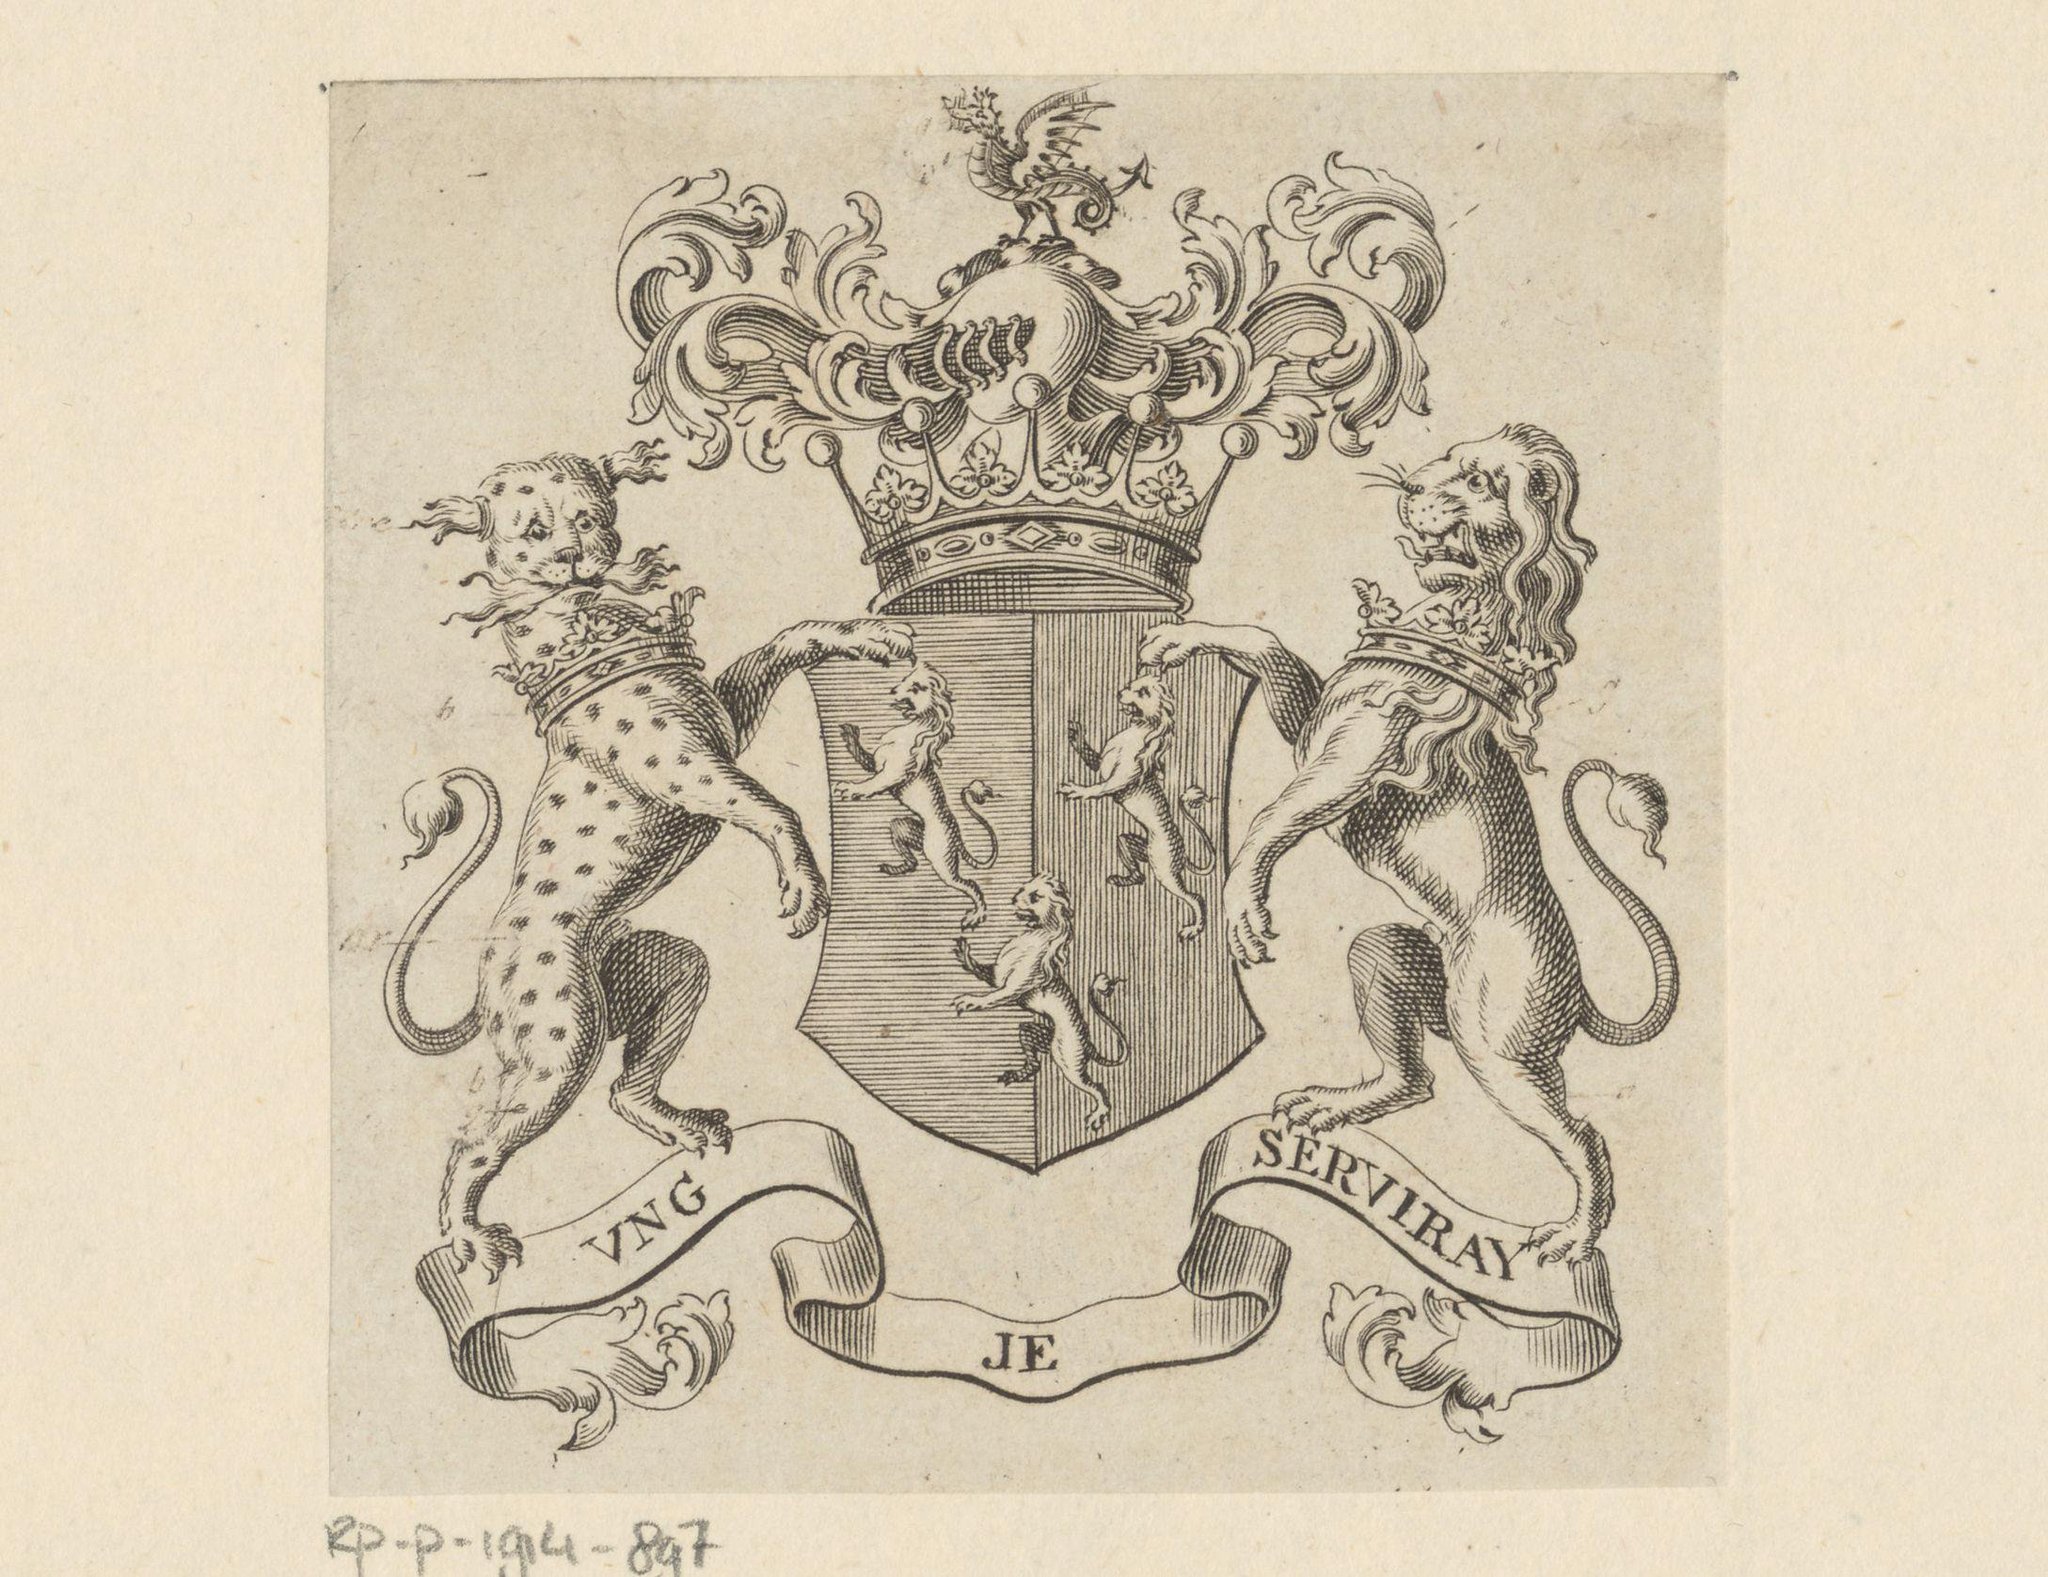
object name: bookplate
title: Ung je Saviray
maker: Anonymous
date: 1700-1899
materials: paper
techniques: engraving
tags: armorial bearing, heraldry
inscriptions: collector's mark: Lugt 2233, collector's mark: Lugt 2760